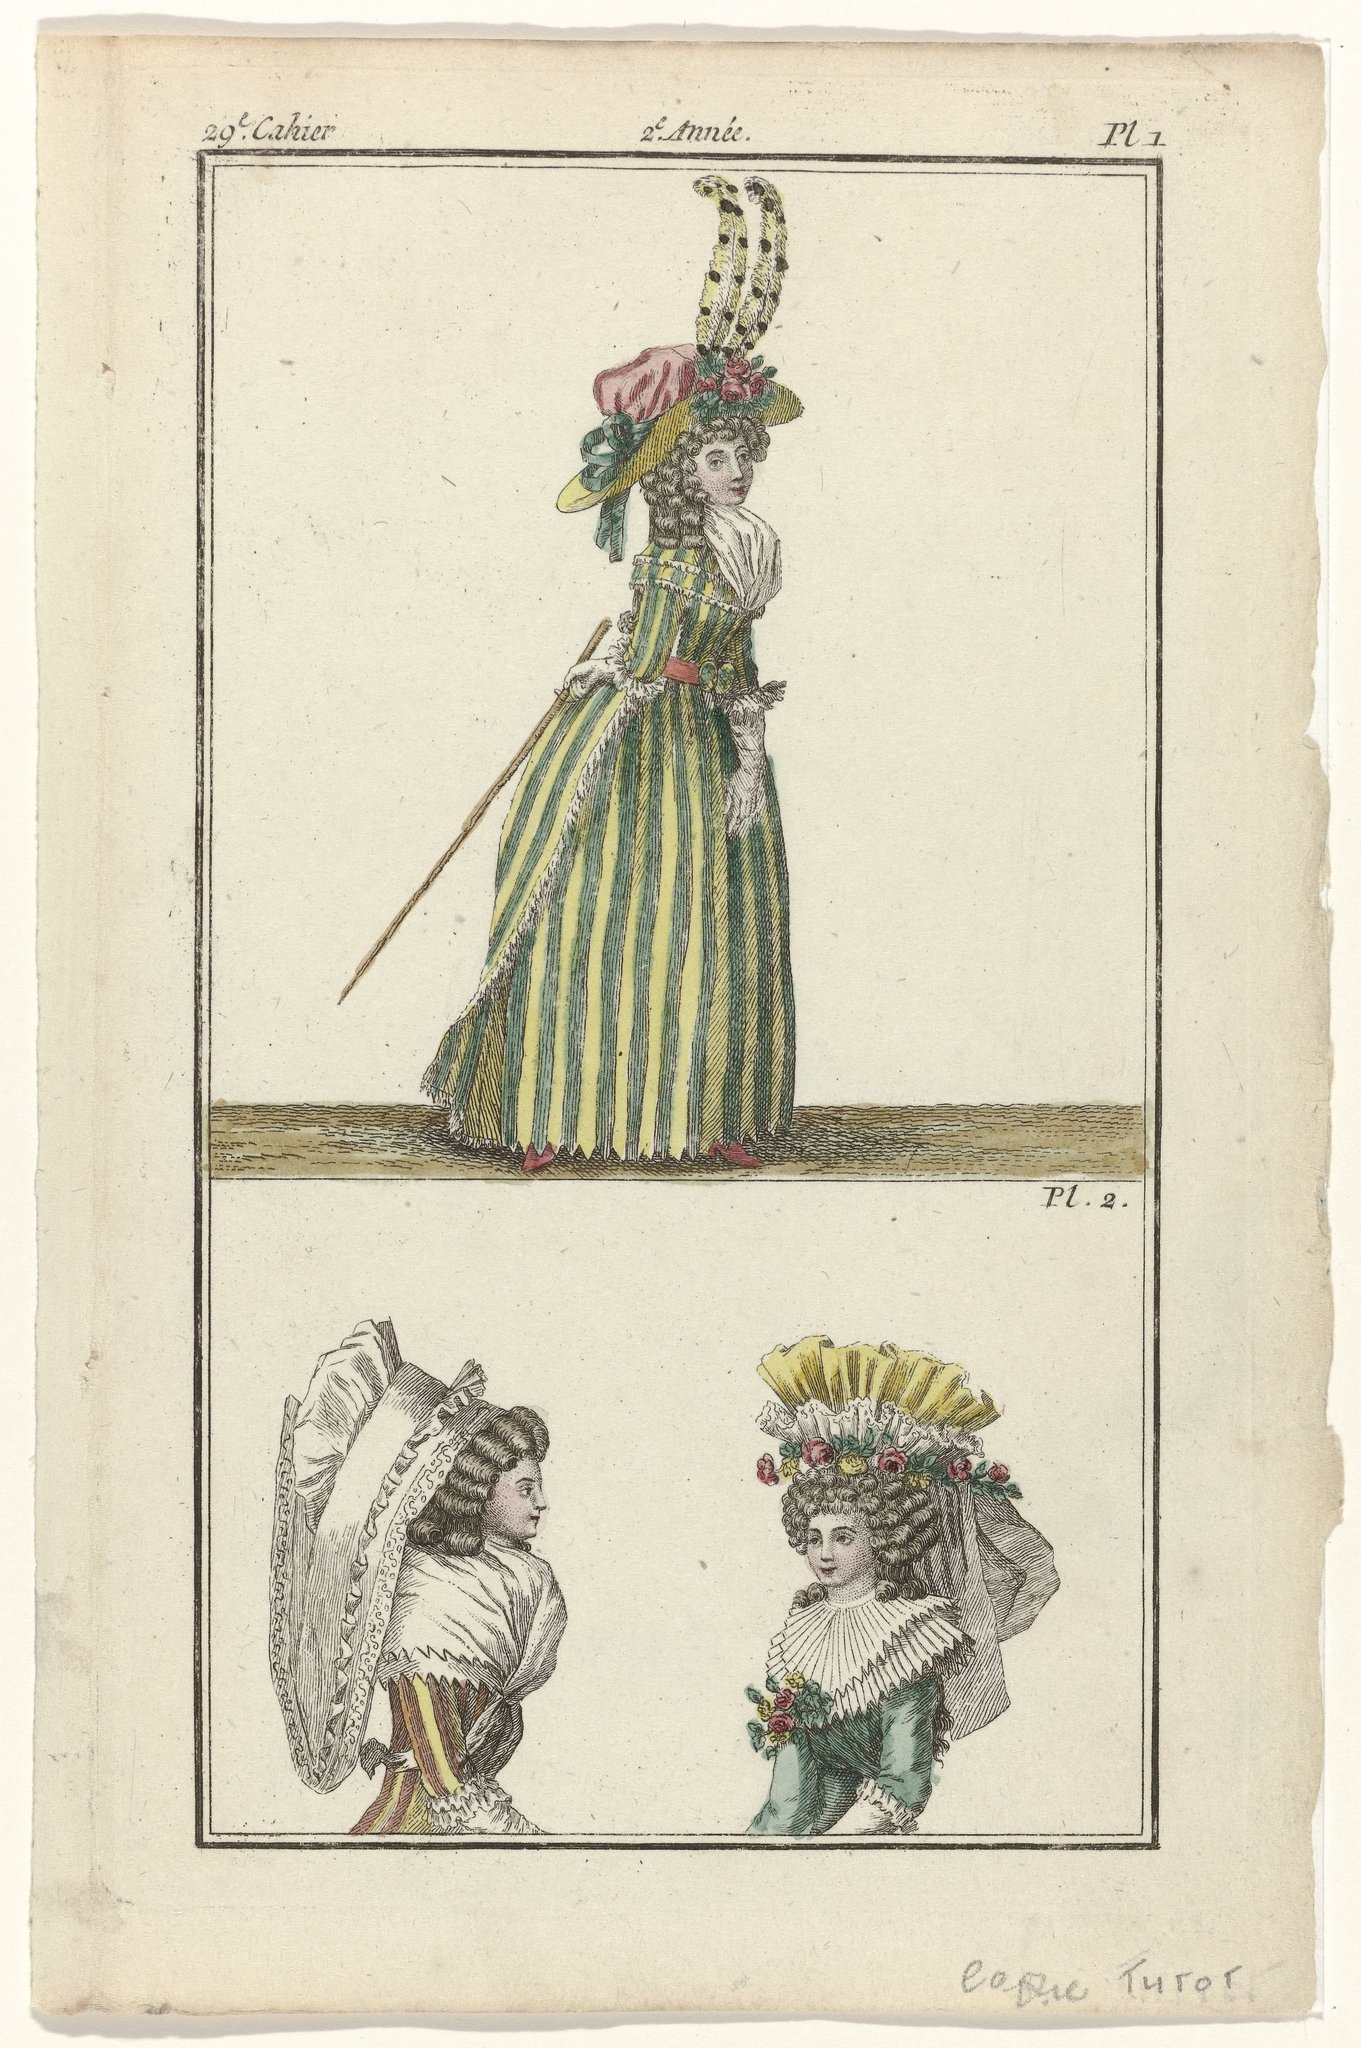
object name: fashion print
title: Magasin des Modes Nouvelles Françaises et Anglaises, 1787, kopie naar Pl. 1 en Pl. 2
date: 1787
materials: paper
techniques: engraving, hand coloring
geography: liège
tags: walking-stick, staff, cane (+ women's clothes), dress, gown: redingote (+ women's clothes), head-gear: cap (+ women's clothes), fashion plates, skirt (+ women's clothes), gloves, mittens, etc. (+ women's clothes), piece of clothing covering the breast or décolleté (fichu) (+ women's clothes)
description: Het bovenste kader: vrouw naar rechts in een gestreepte demi redingote met bijpassende rok. Om de hals een fichu. Accessoires: hoed met twee veren, ceintuur, wandelstok, schoenen met hakken. Het onderste kader: twee vrouwenbustes: rechts: bonnet bestaande uit twee geplooide lagen, versierd met bloemen; links: een cauchoise van linnen. De prent is een kopie naar Pl.1 en Pl. 2 van het 29e Cahier, 2e année, uit de serie Magasin des Modes Nouvelles Françaises et Anglaises. De twee prenten zijn gekopieerd in spiegelbeeld op één vel in de kopie uitgave door J.J. Tuttot, Liège (Luik), van nov. 1786 tot nov. 1787. Zijn tijdschrift verscheen korte tijd onder dezelfde naam.